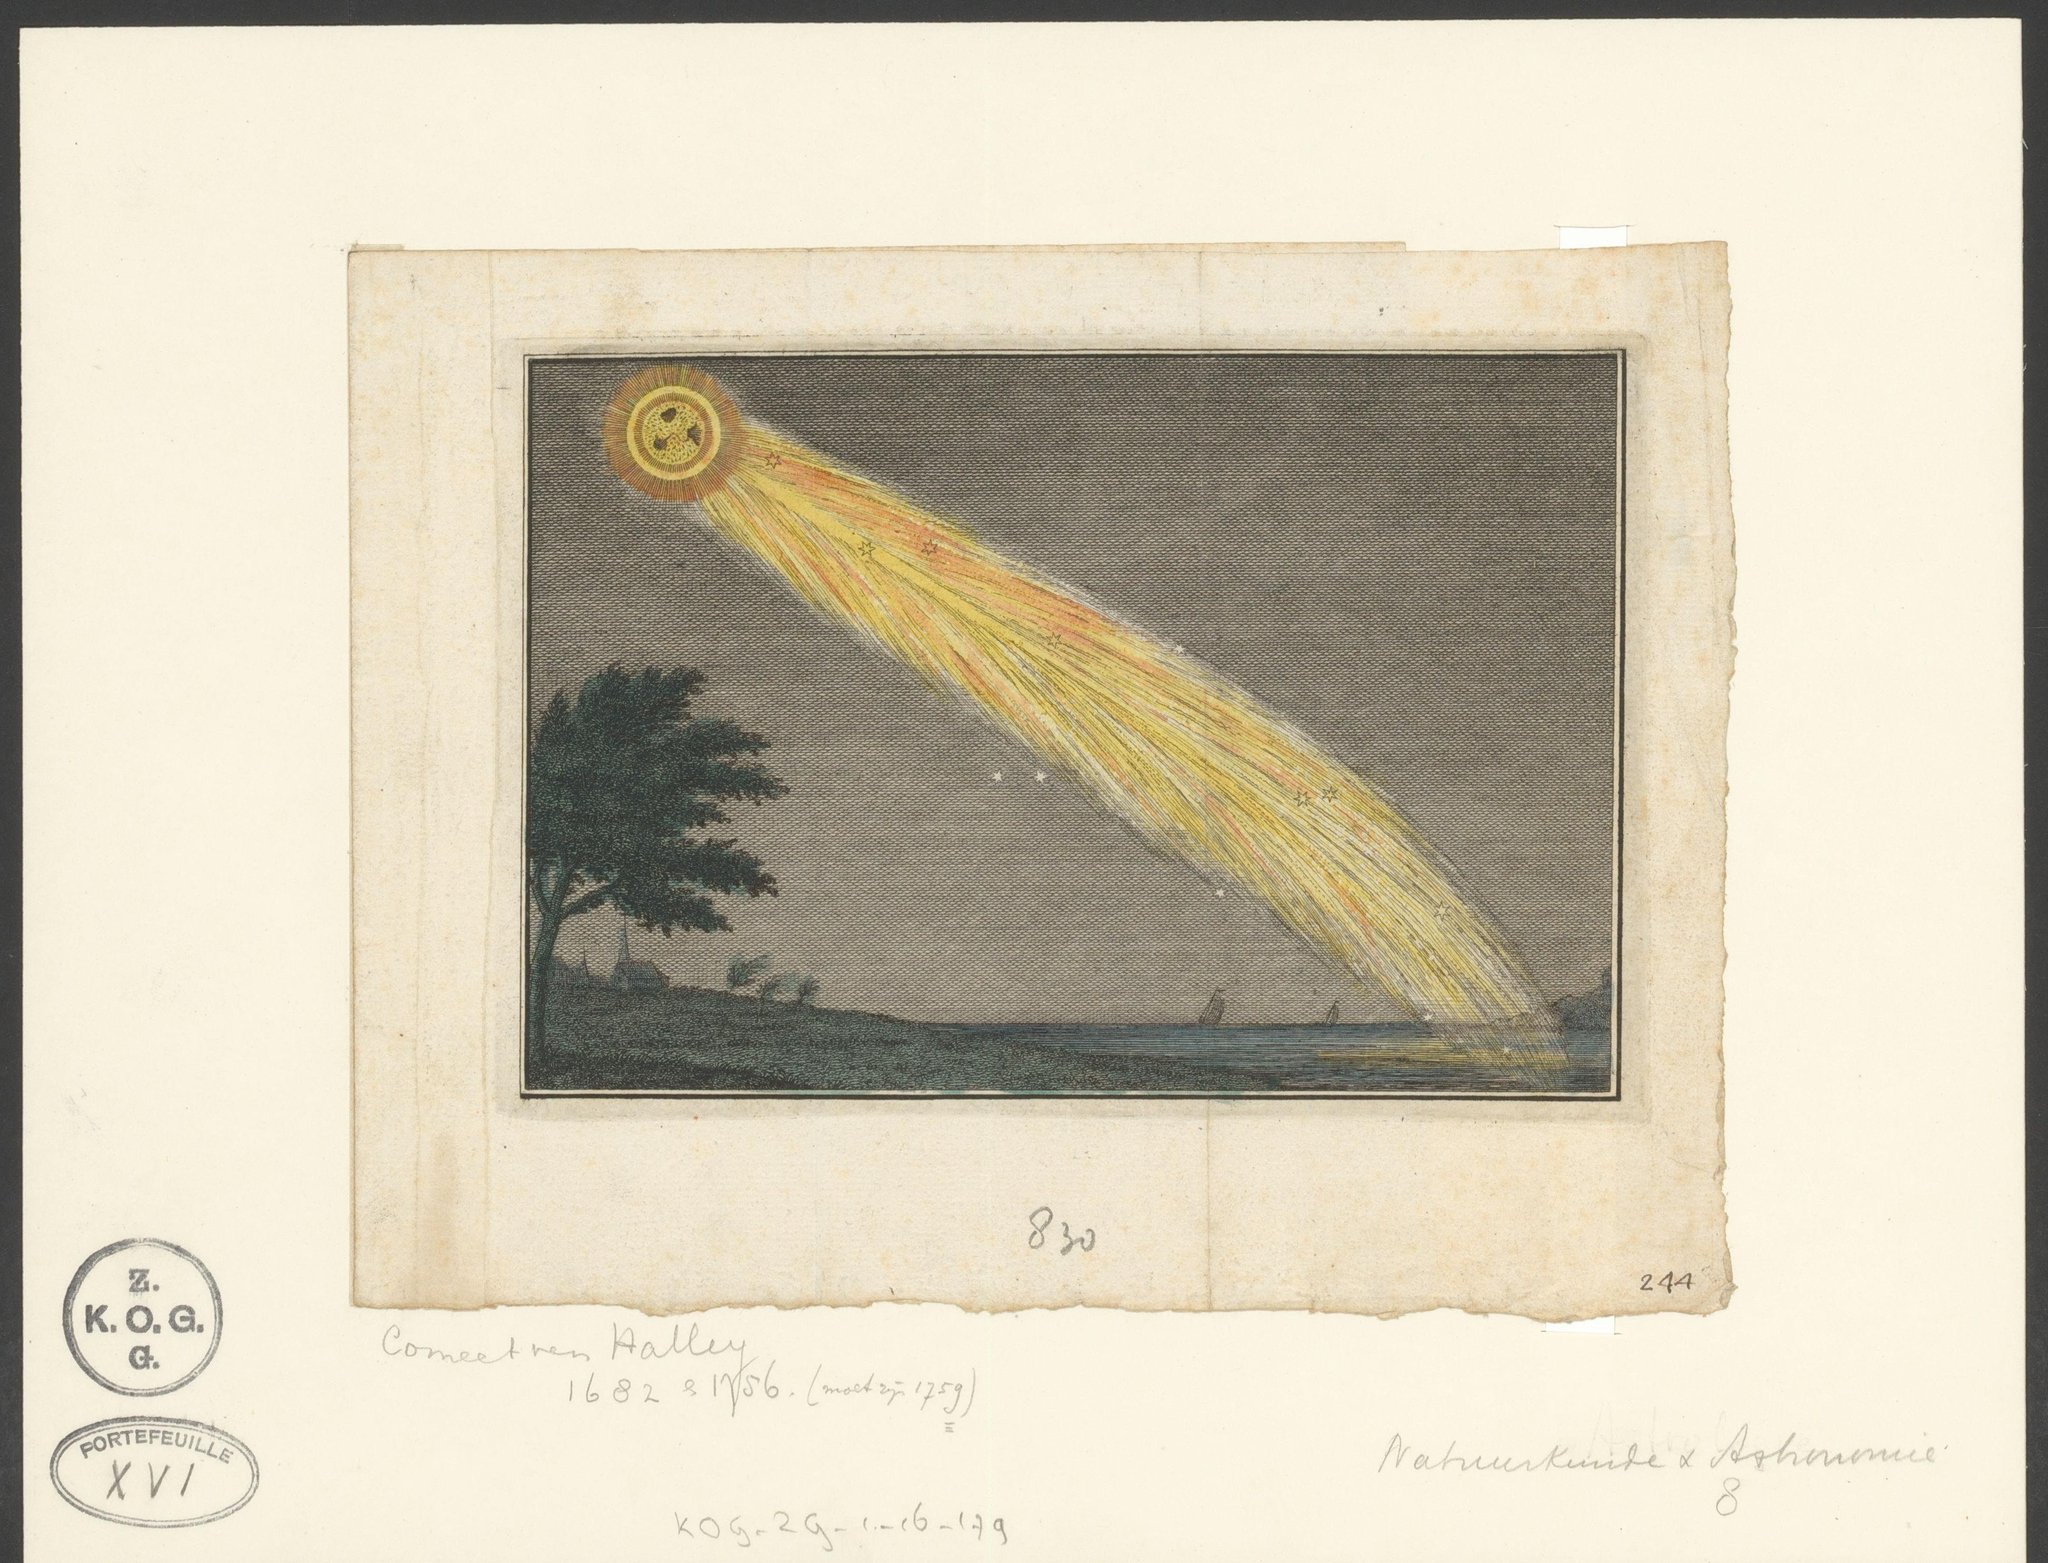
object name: print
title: Komeet, waarschijnlijk komeet Halley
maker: Anonymous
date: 1759-1799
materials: paper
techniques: engraving, etching, hand coloring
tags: comet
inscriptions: stamp, inscription: ‘Deze Comeet heeft zig in 1682 vertoont zoo als hij hier is, en in 1756 in Junij weder.’, collector's mark: Lugt 1641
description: Een komeet, waarschijnlijk komeet Halley. Deze komeet verschijnt ongeveer iedere 76 jaar. In Nederland was deze komeet te zien in 1682 en 1759. Rechtsonder genummerd met pen: 244. Onderwerpsrubrieken binnen de Atlas Zeden en Gewoonten: Onderwijs en Wetenschappen, Astrologen (Natuurkunde en Astronomie).